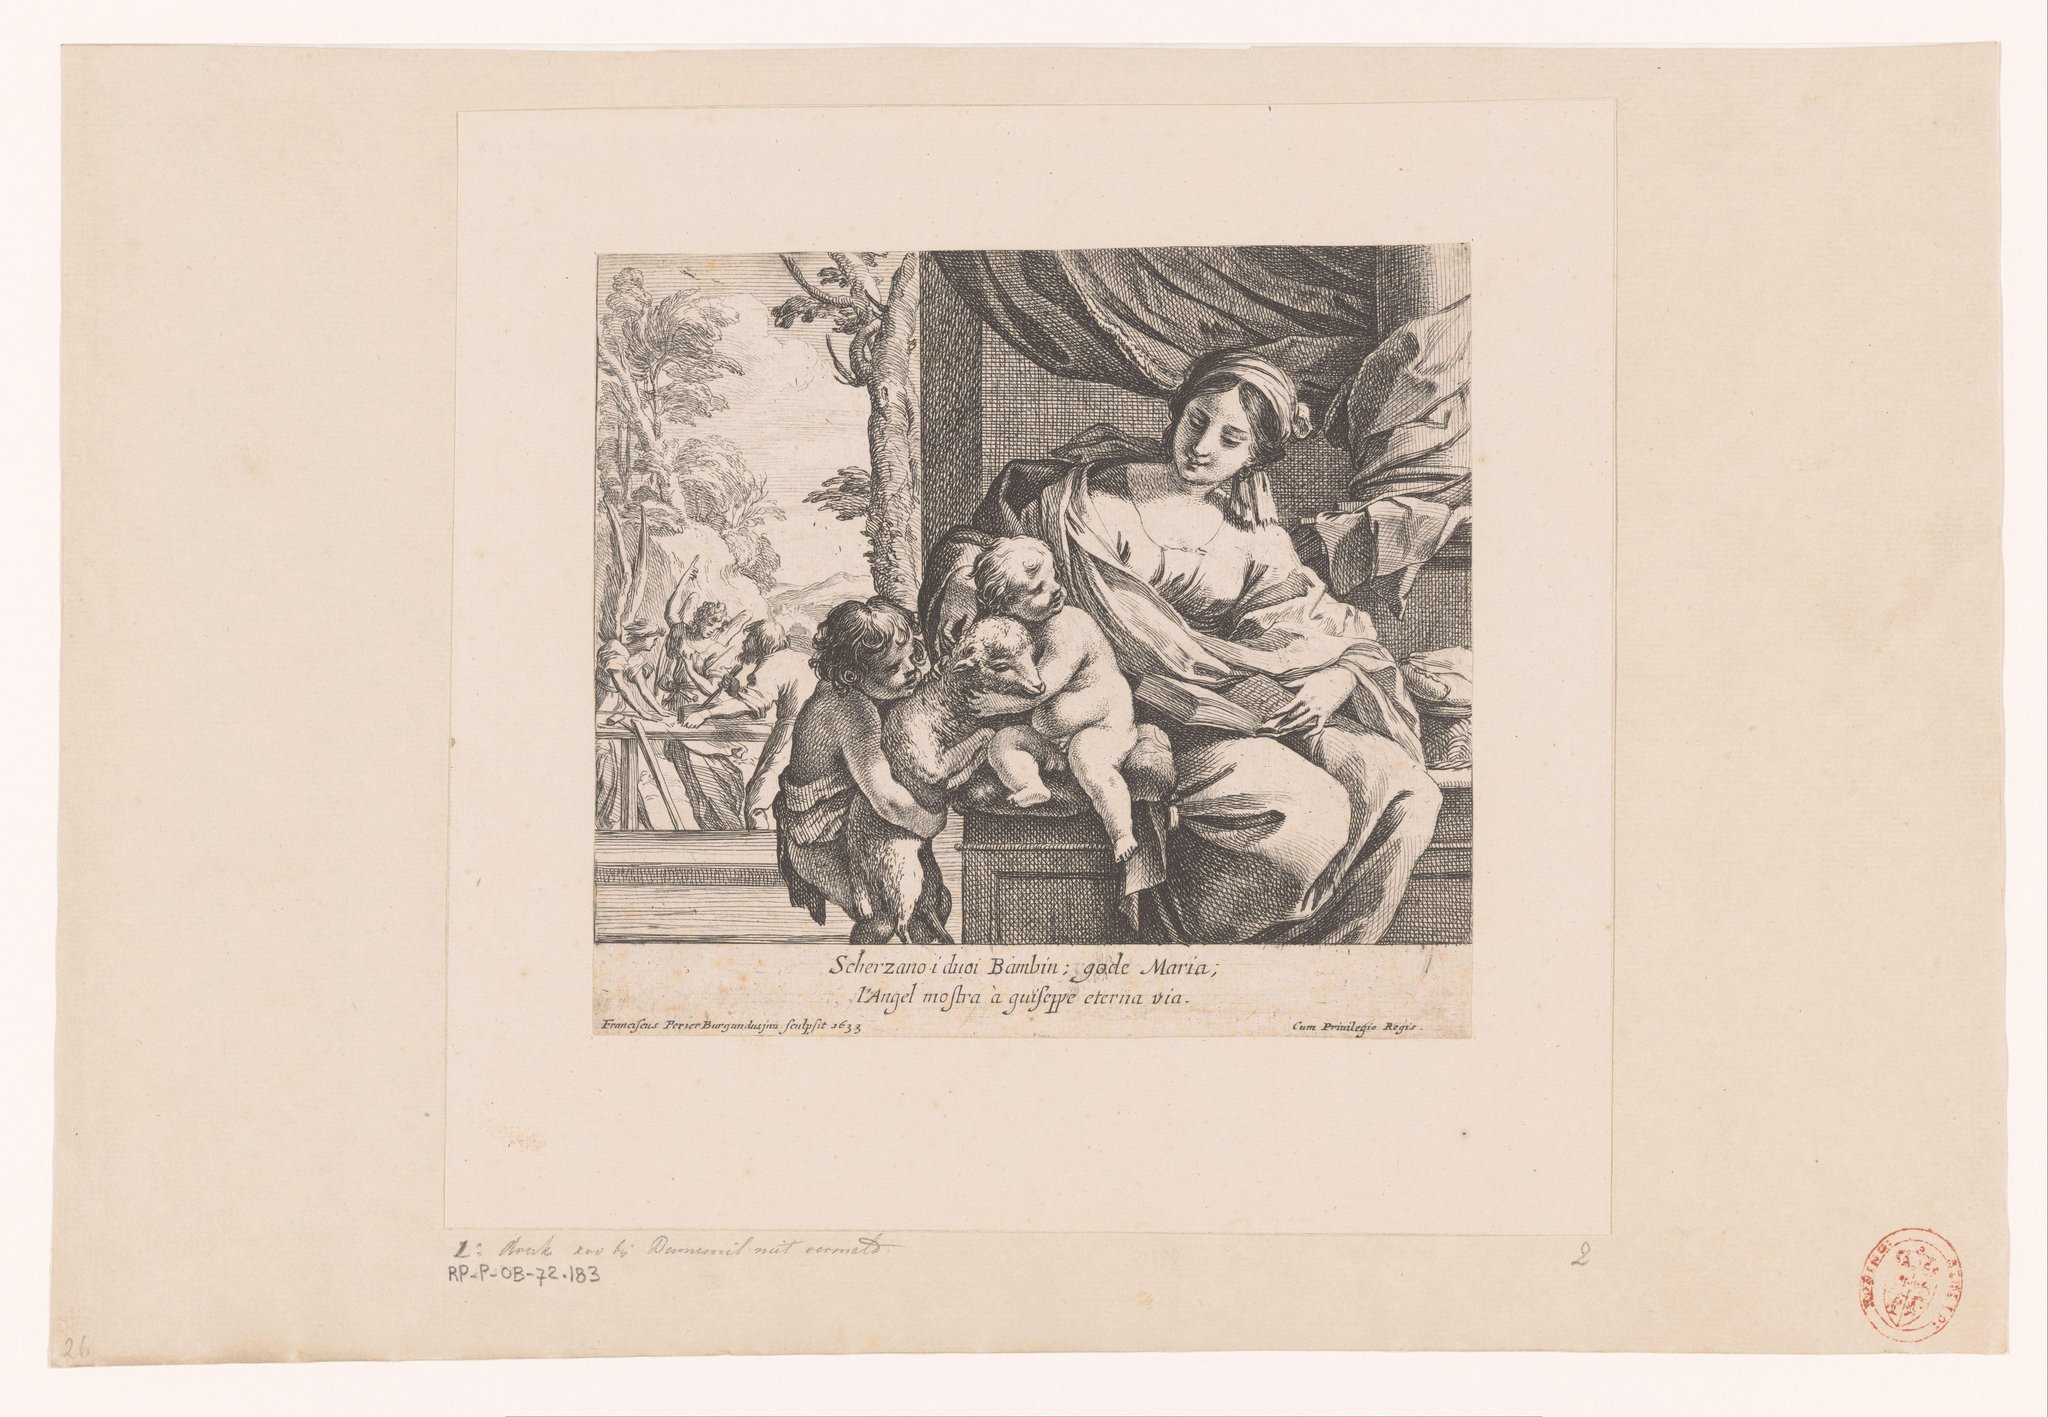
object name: print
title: Scherzano i duoi Bambin (...)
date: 1633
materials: paper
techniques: etching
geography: france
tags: mary and the christ-child with john the baptist (as child), christ-child playing with lamb ~ madonna-representations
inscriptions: collector's mark: Lugt 240